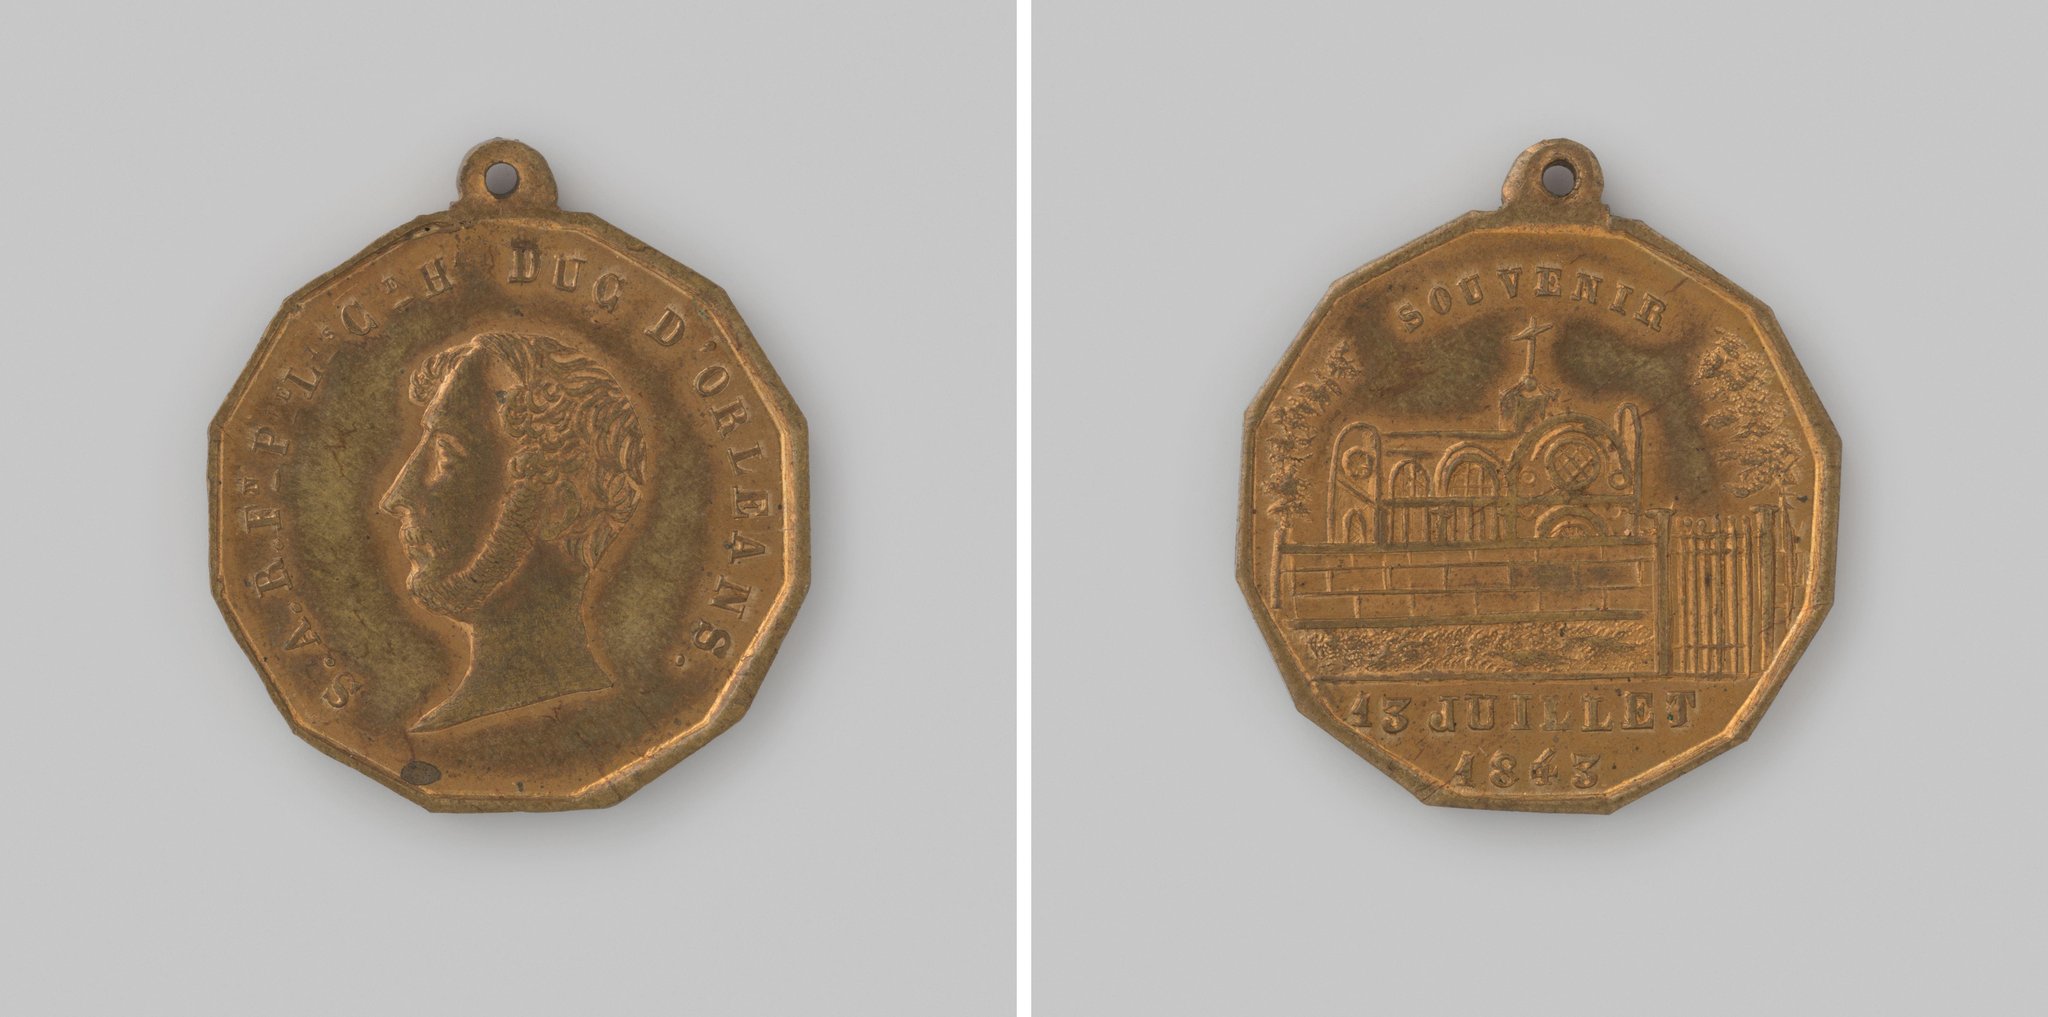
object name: history medal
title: Oprichting van de Kapel St Ferdinand ter ere van de hertog van Orléans 1843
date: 1843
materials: brass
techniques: striking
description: Twaalfhoekige messing penning met draagoog, op de voorzijde het portret van de Hertog van Orleans naar links met omschrift, op de keerzijde het aanzicht van een ommuurde kapel met omschrift en afsnedetekst.